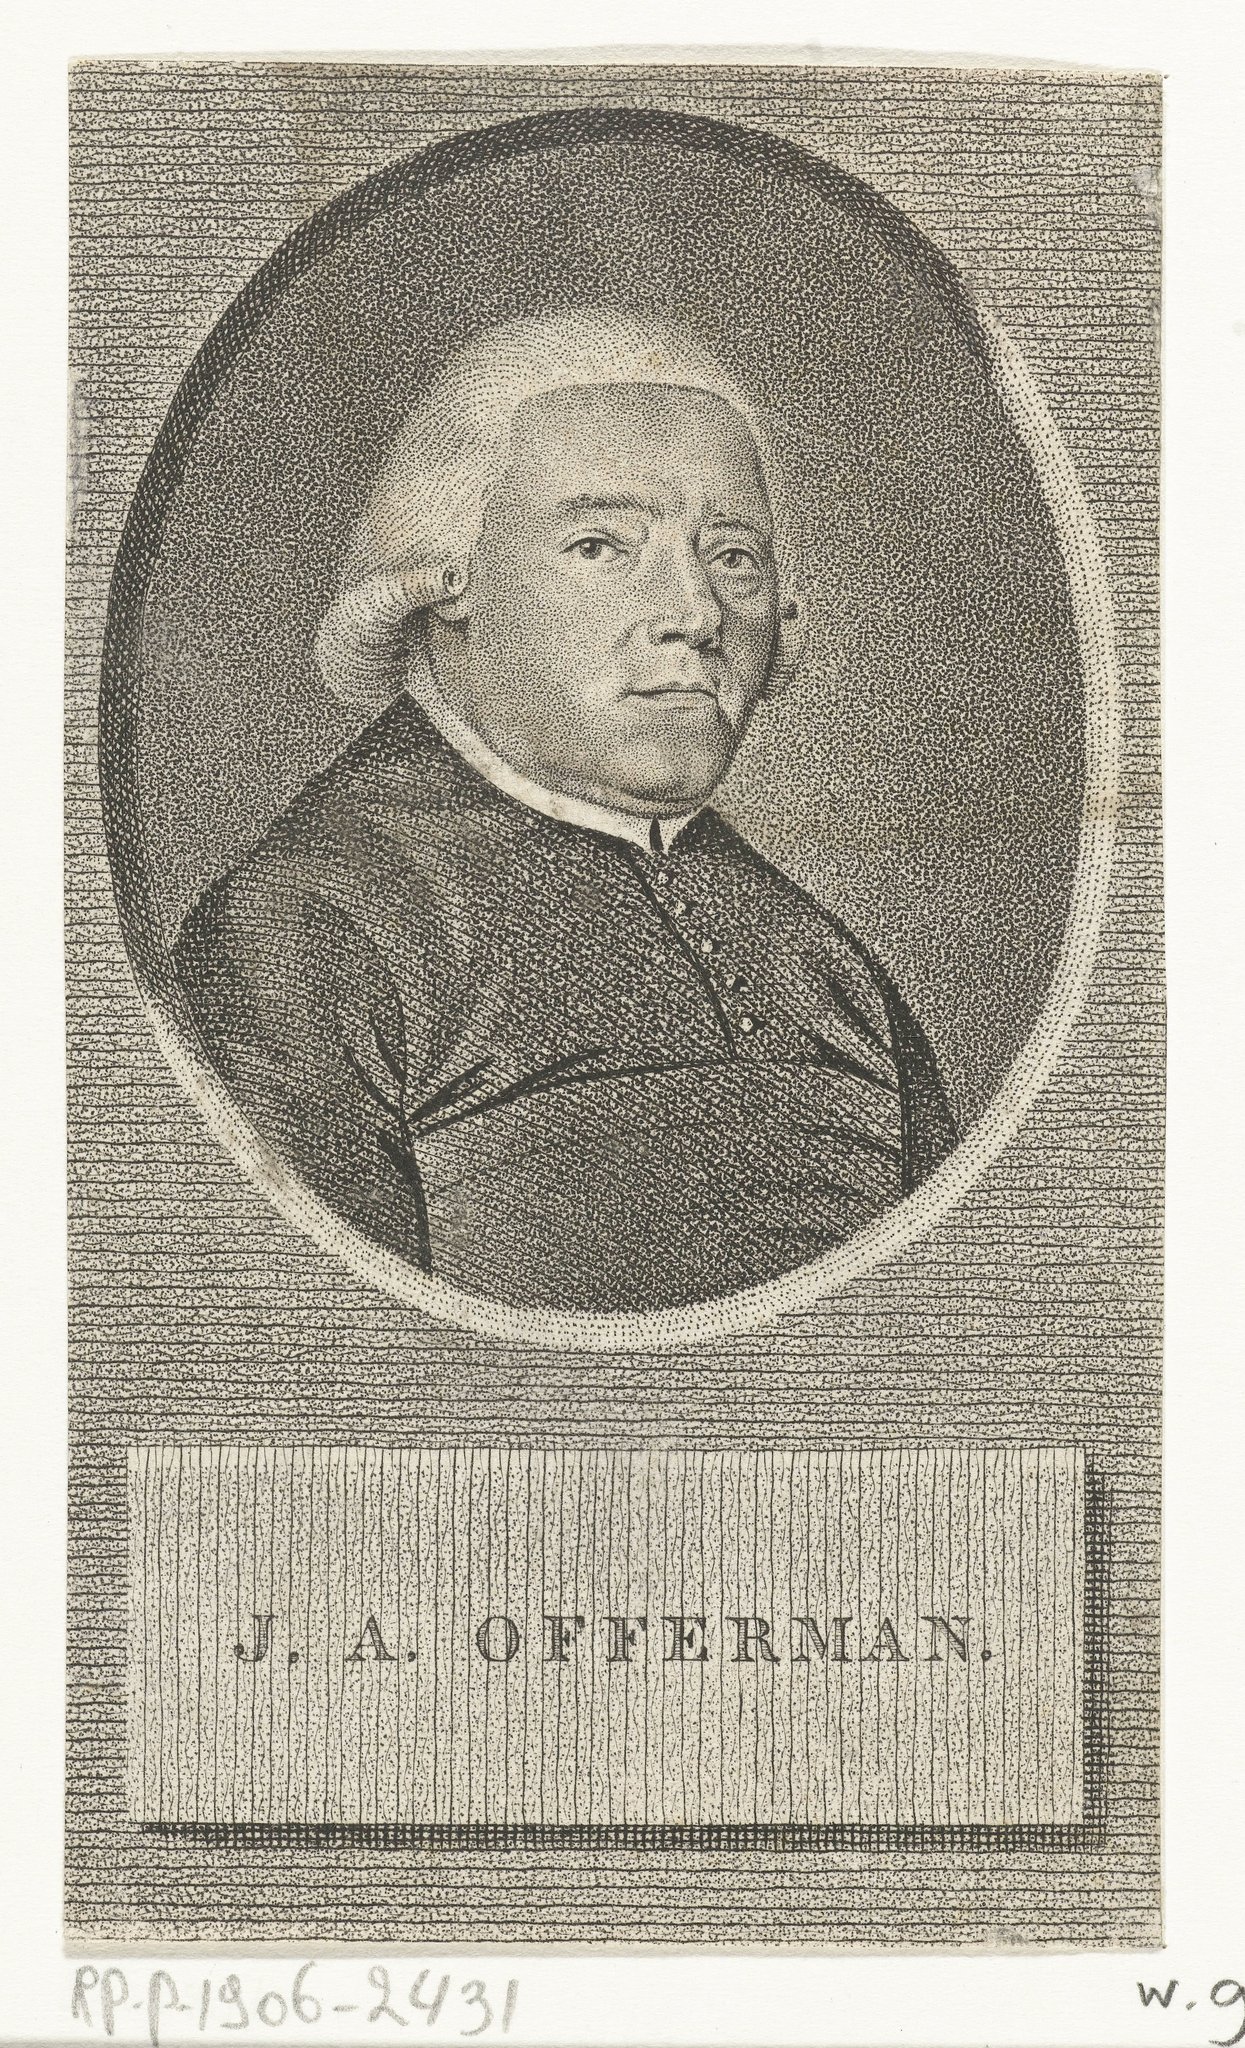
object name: print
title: Portret van Joës Andreas Offerman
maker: jan willem caspari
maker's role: print maker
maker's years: 1779-1822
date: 1789-1822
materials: paper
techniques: etching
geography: amsterdam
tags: priest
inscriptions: collector's mark: Lugt 2228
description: Portret in ovale lijst van Joës Andreas Offerman, een priester uit Amsterdam. Buste naar rechts. Offerman draagt een soutane met een witte priesterboord.